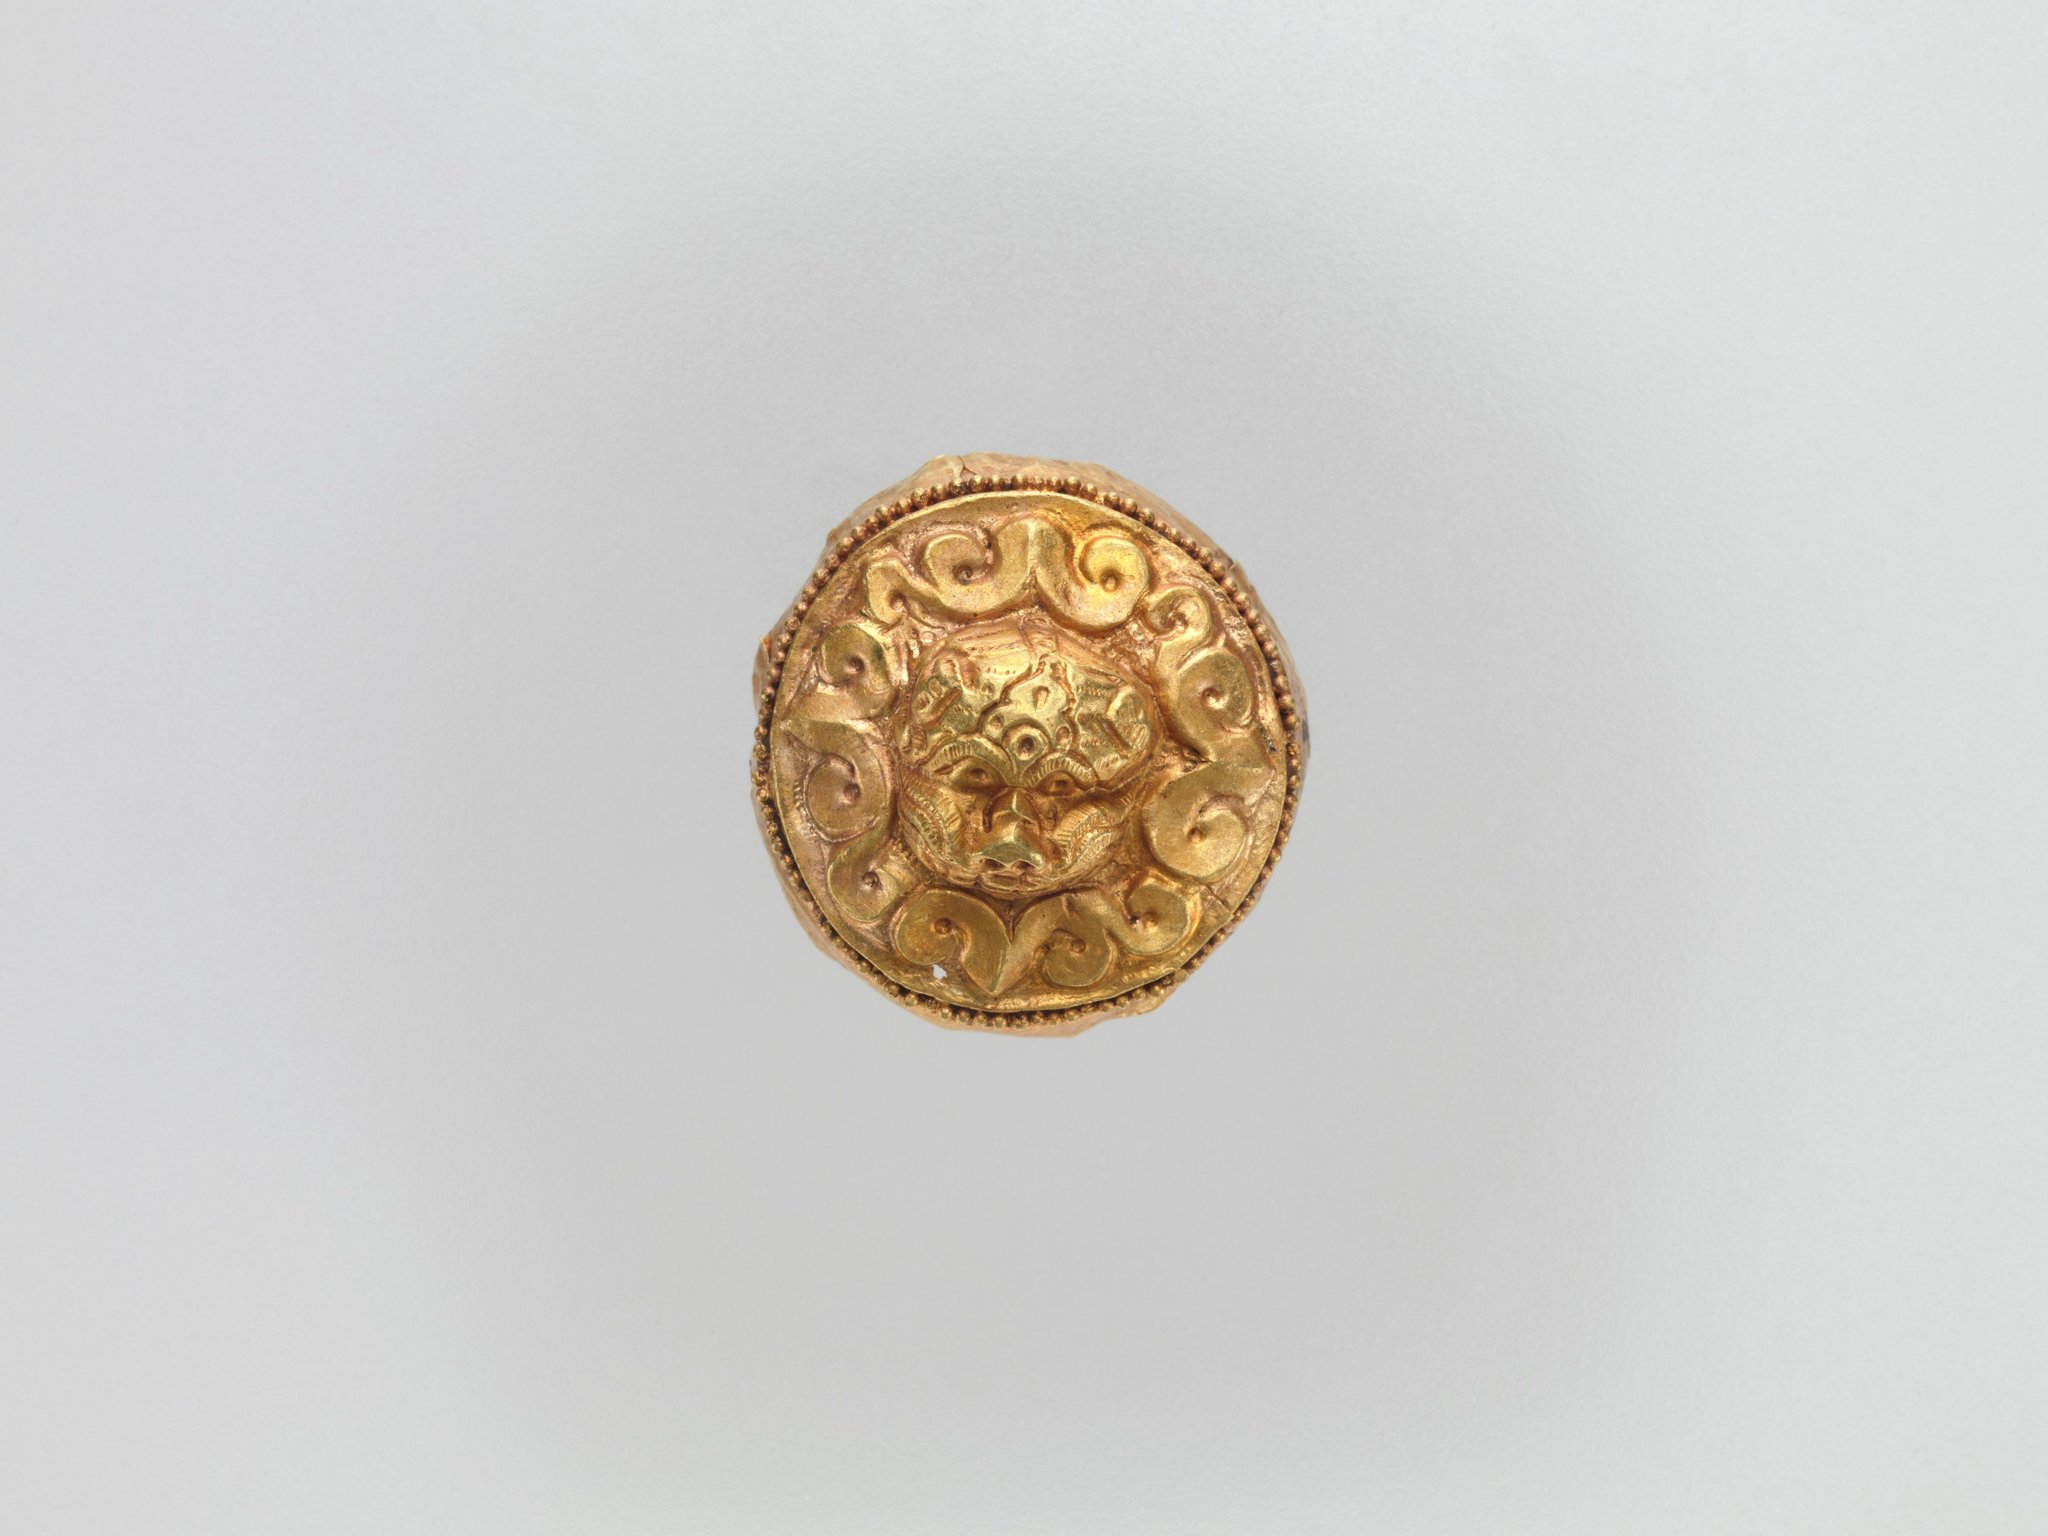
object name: plaque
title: Cap-Shaped Plaque with Lion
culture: chinese or central asian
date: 601-900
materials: gold